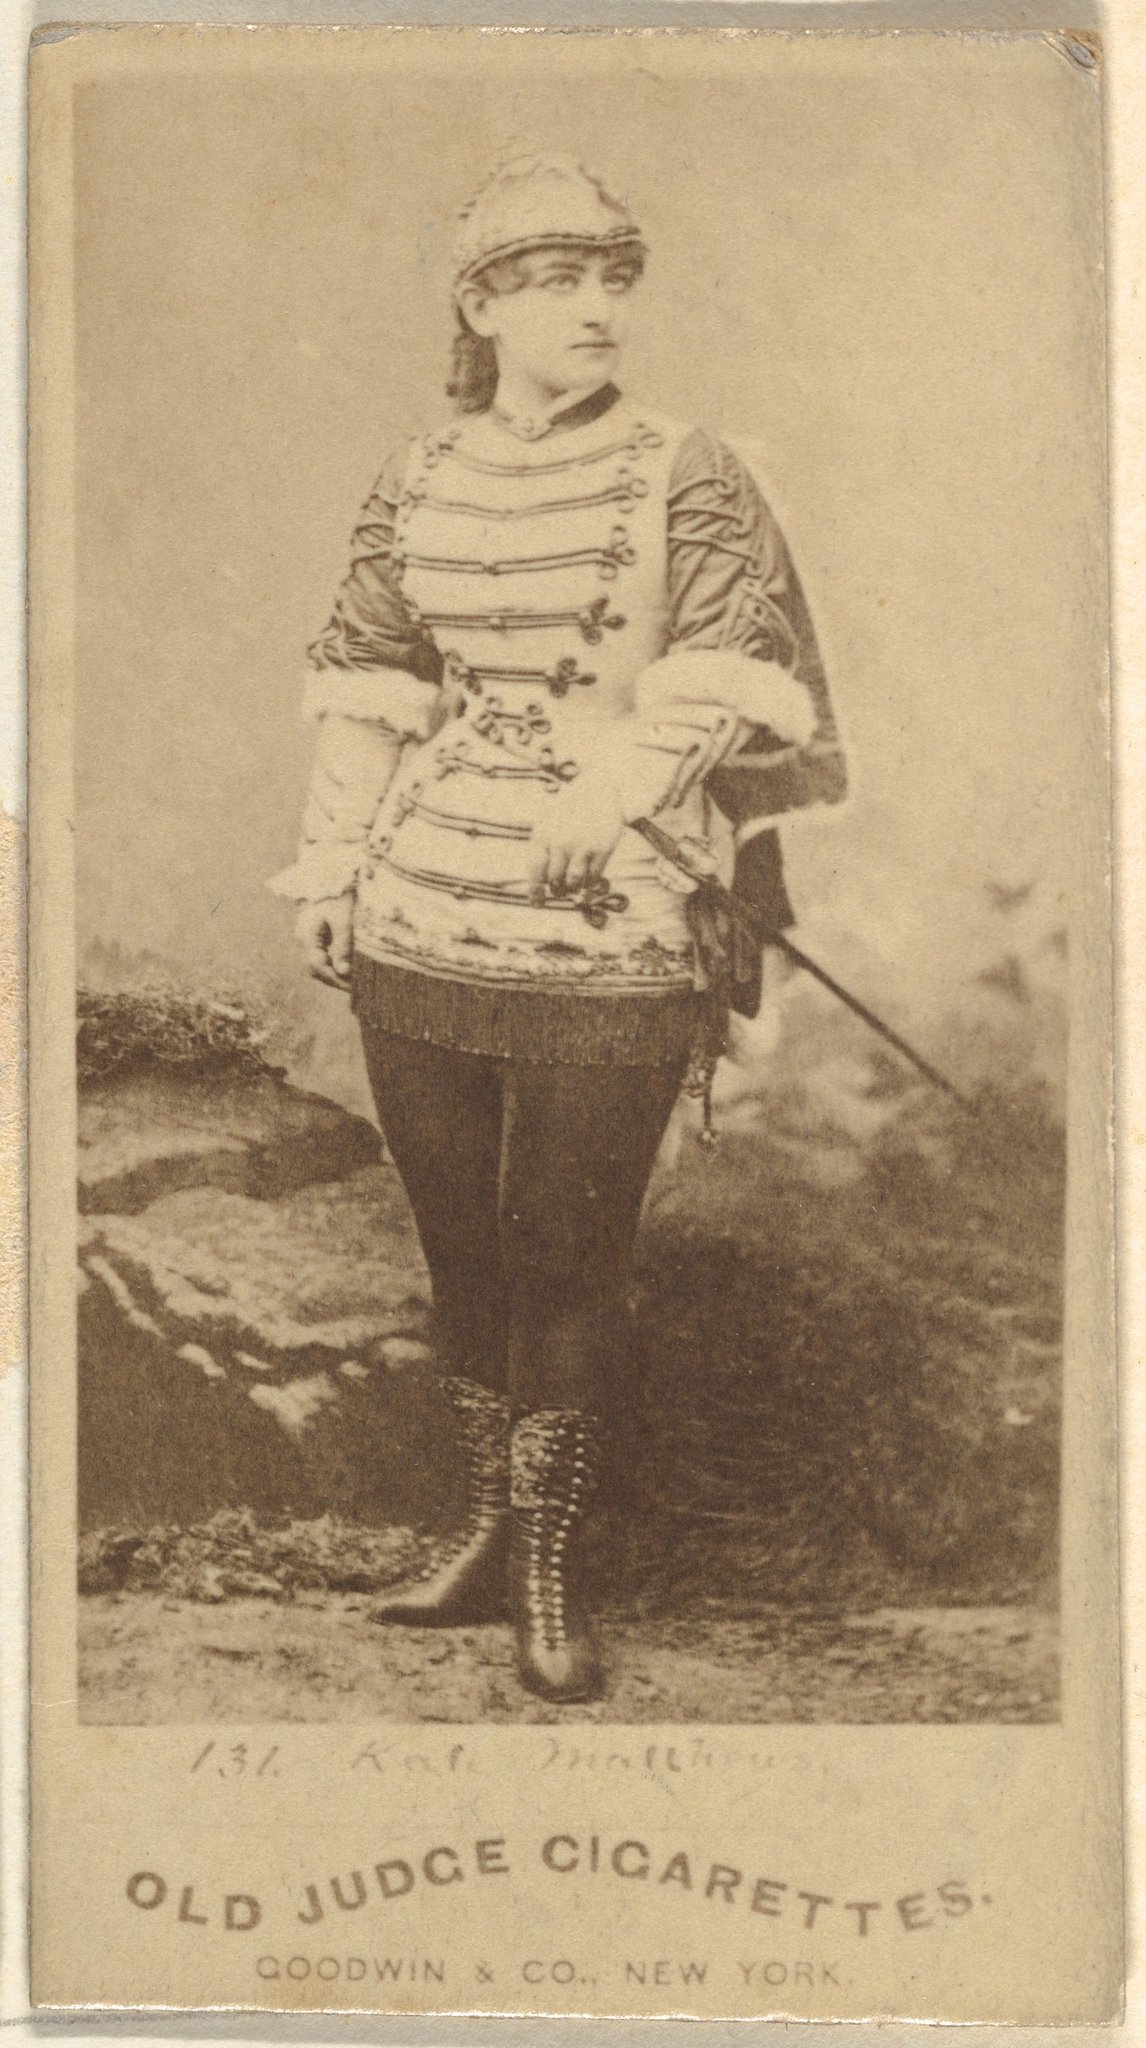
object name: photograph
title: From the Actors and Actresses series (N171) for Old Judge Cigarettes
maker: goodwin & company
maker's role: publisher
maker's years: 1850-1950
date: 1886-1890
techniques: albumen silver print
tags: portraits,women,actresses